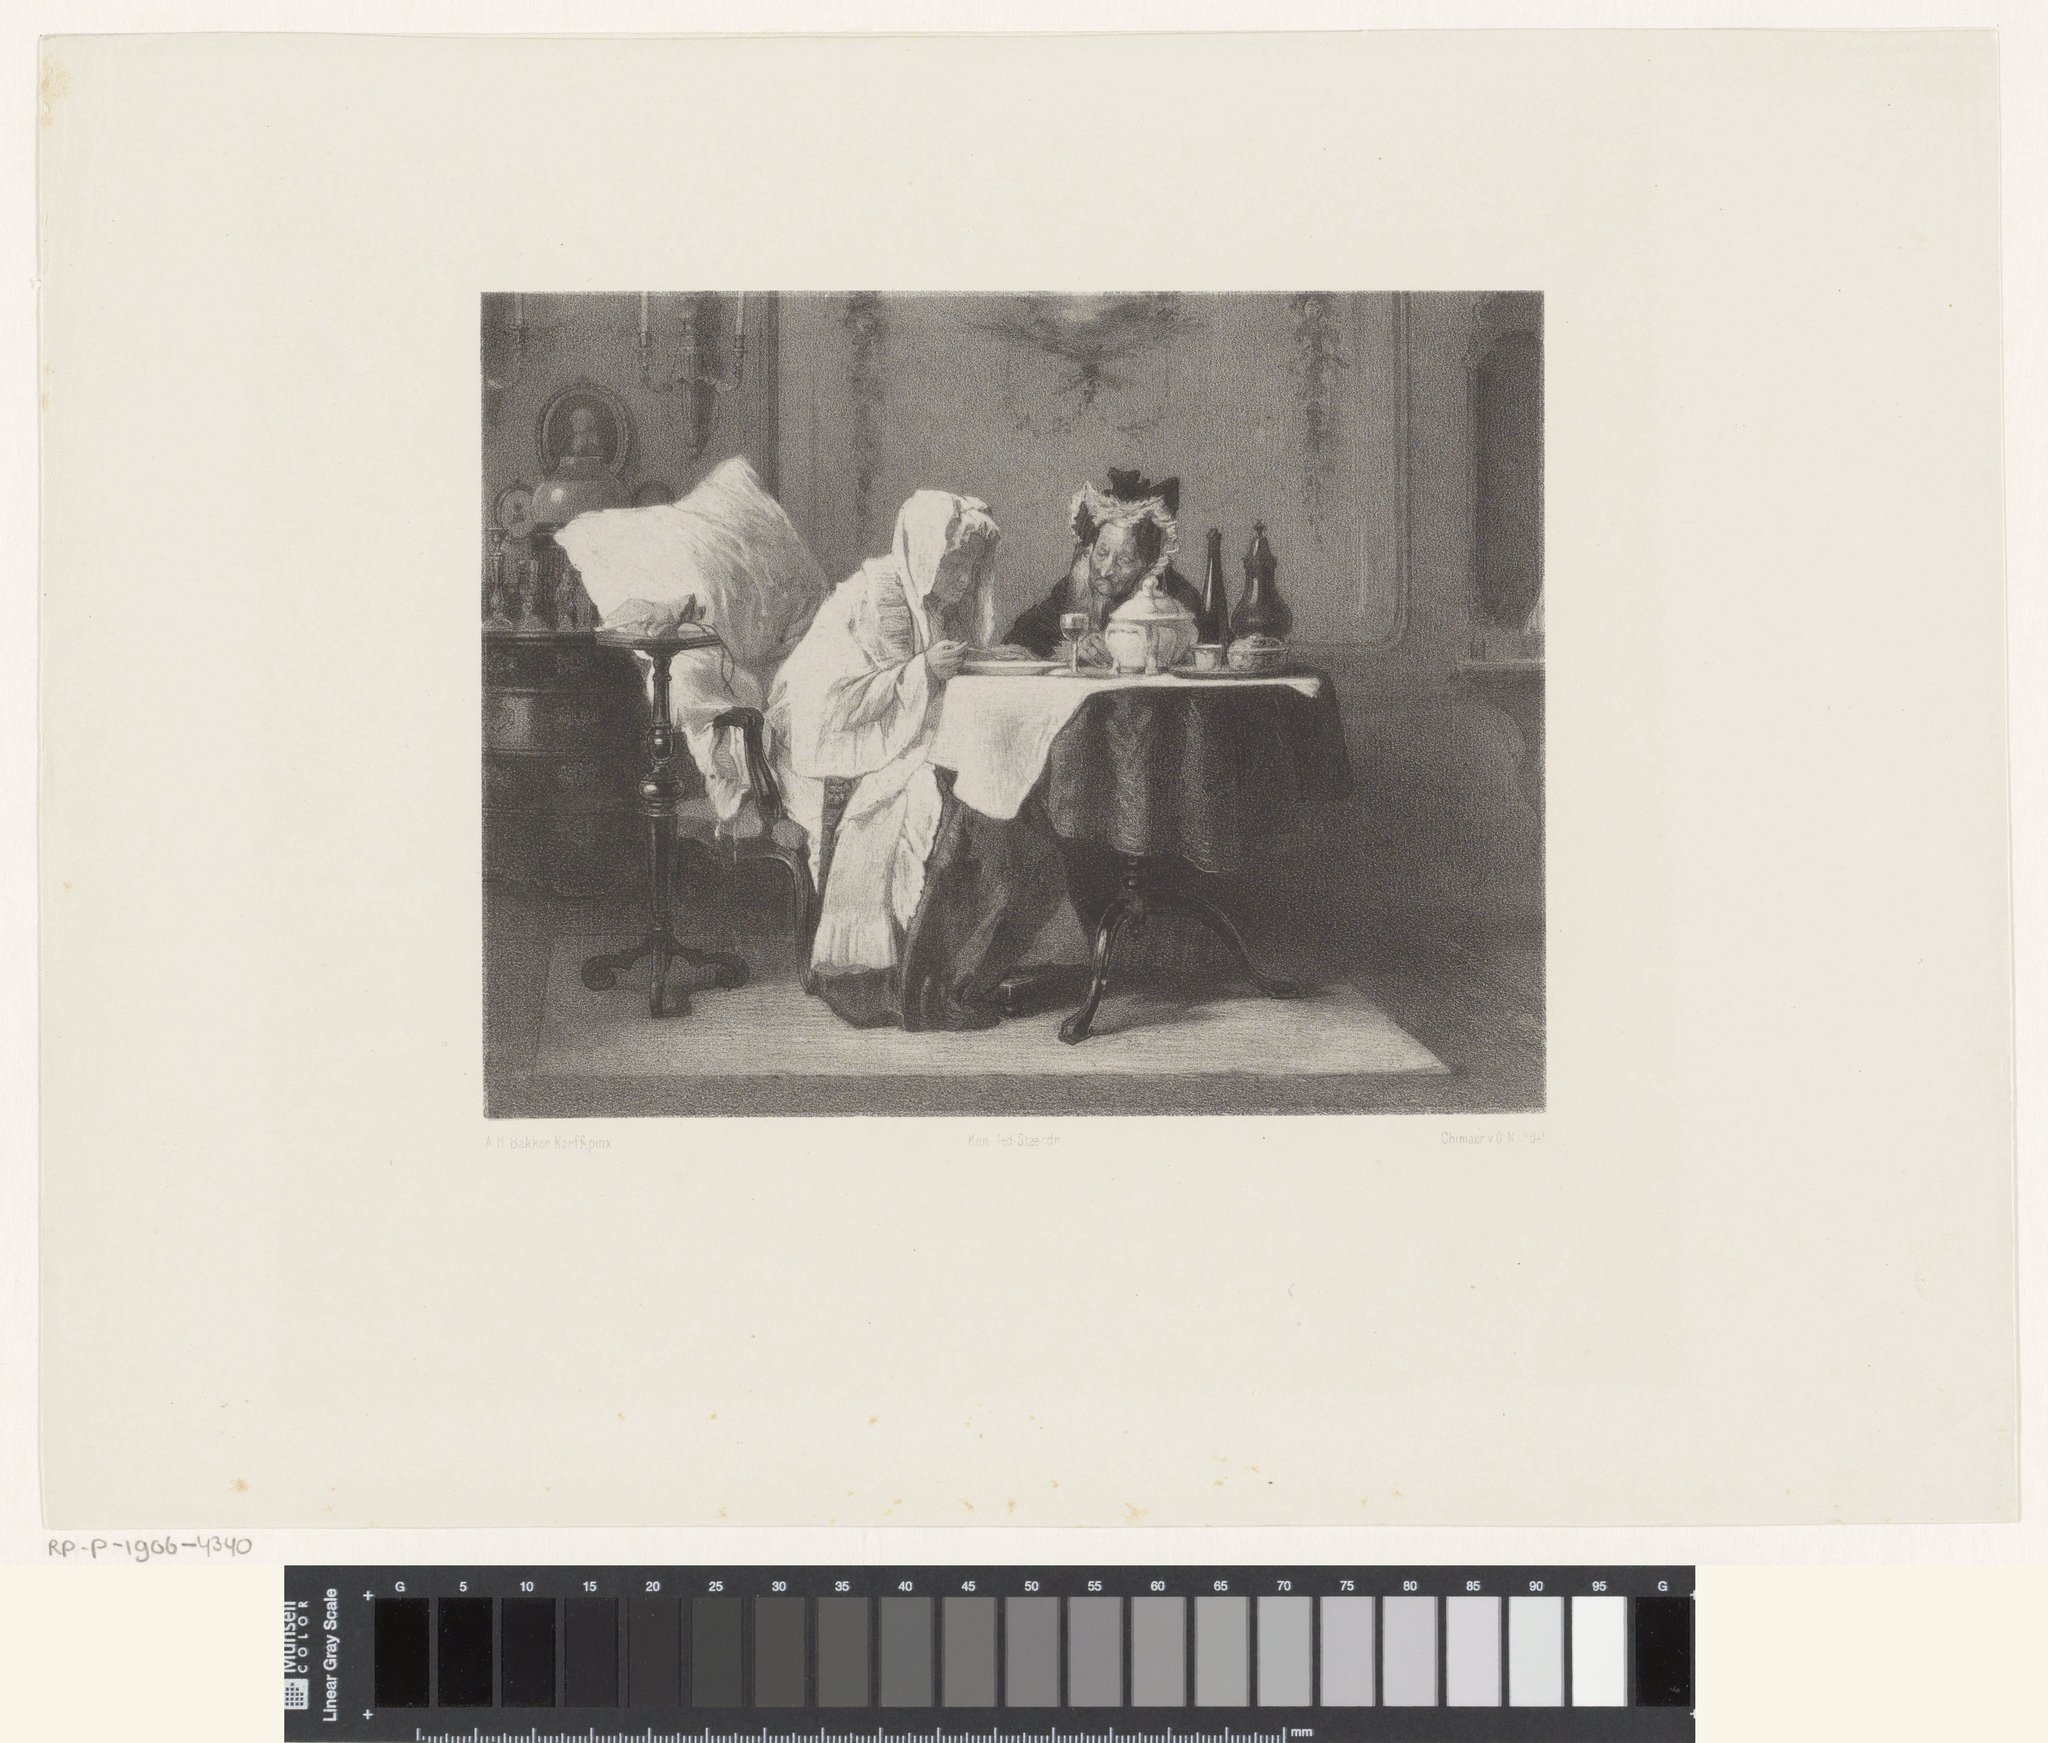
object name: print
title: Twee oude dames eten soep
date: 1867-1873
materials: paper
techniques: lithograph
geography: netherlands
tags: broth, soup (+ taking (particular) foodstuffs: eating, drinking, smoking, chewing, etc.), old woman (+ sitting), pillow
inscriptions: collector's mark: Lugt 2228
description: Een dame heeft een groot kussen achter haar in de stoel gezet. Op tafel staat een soepterrine.